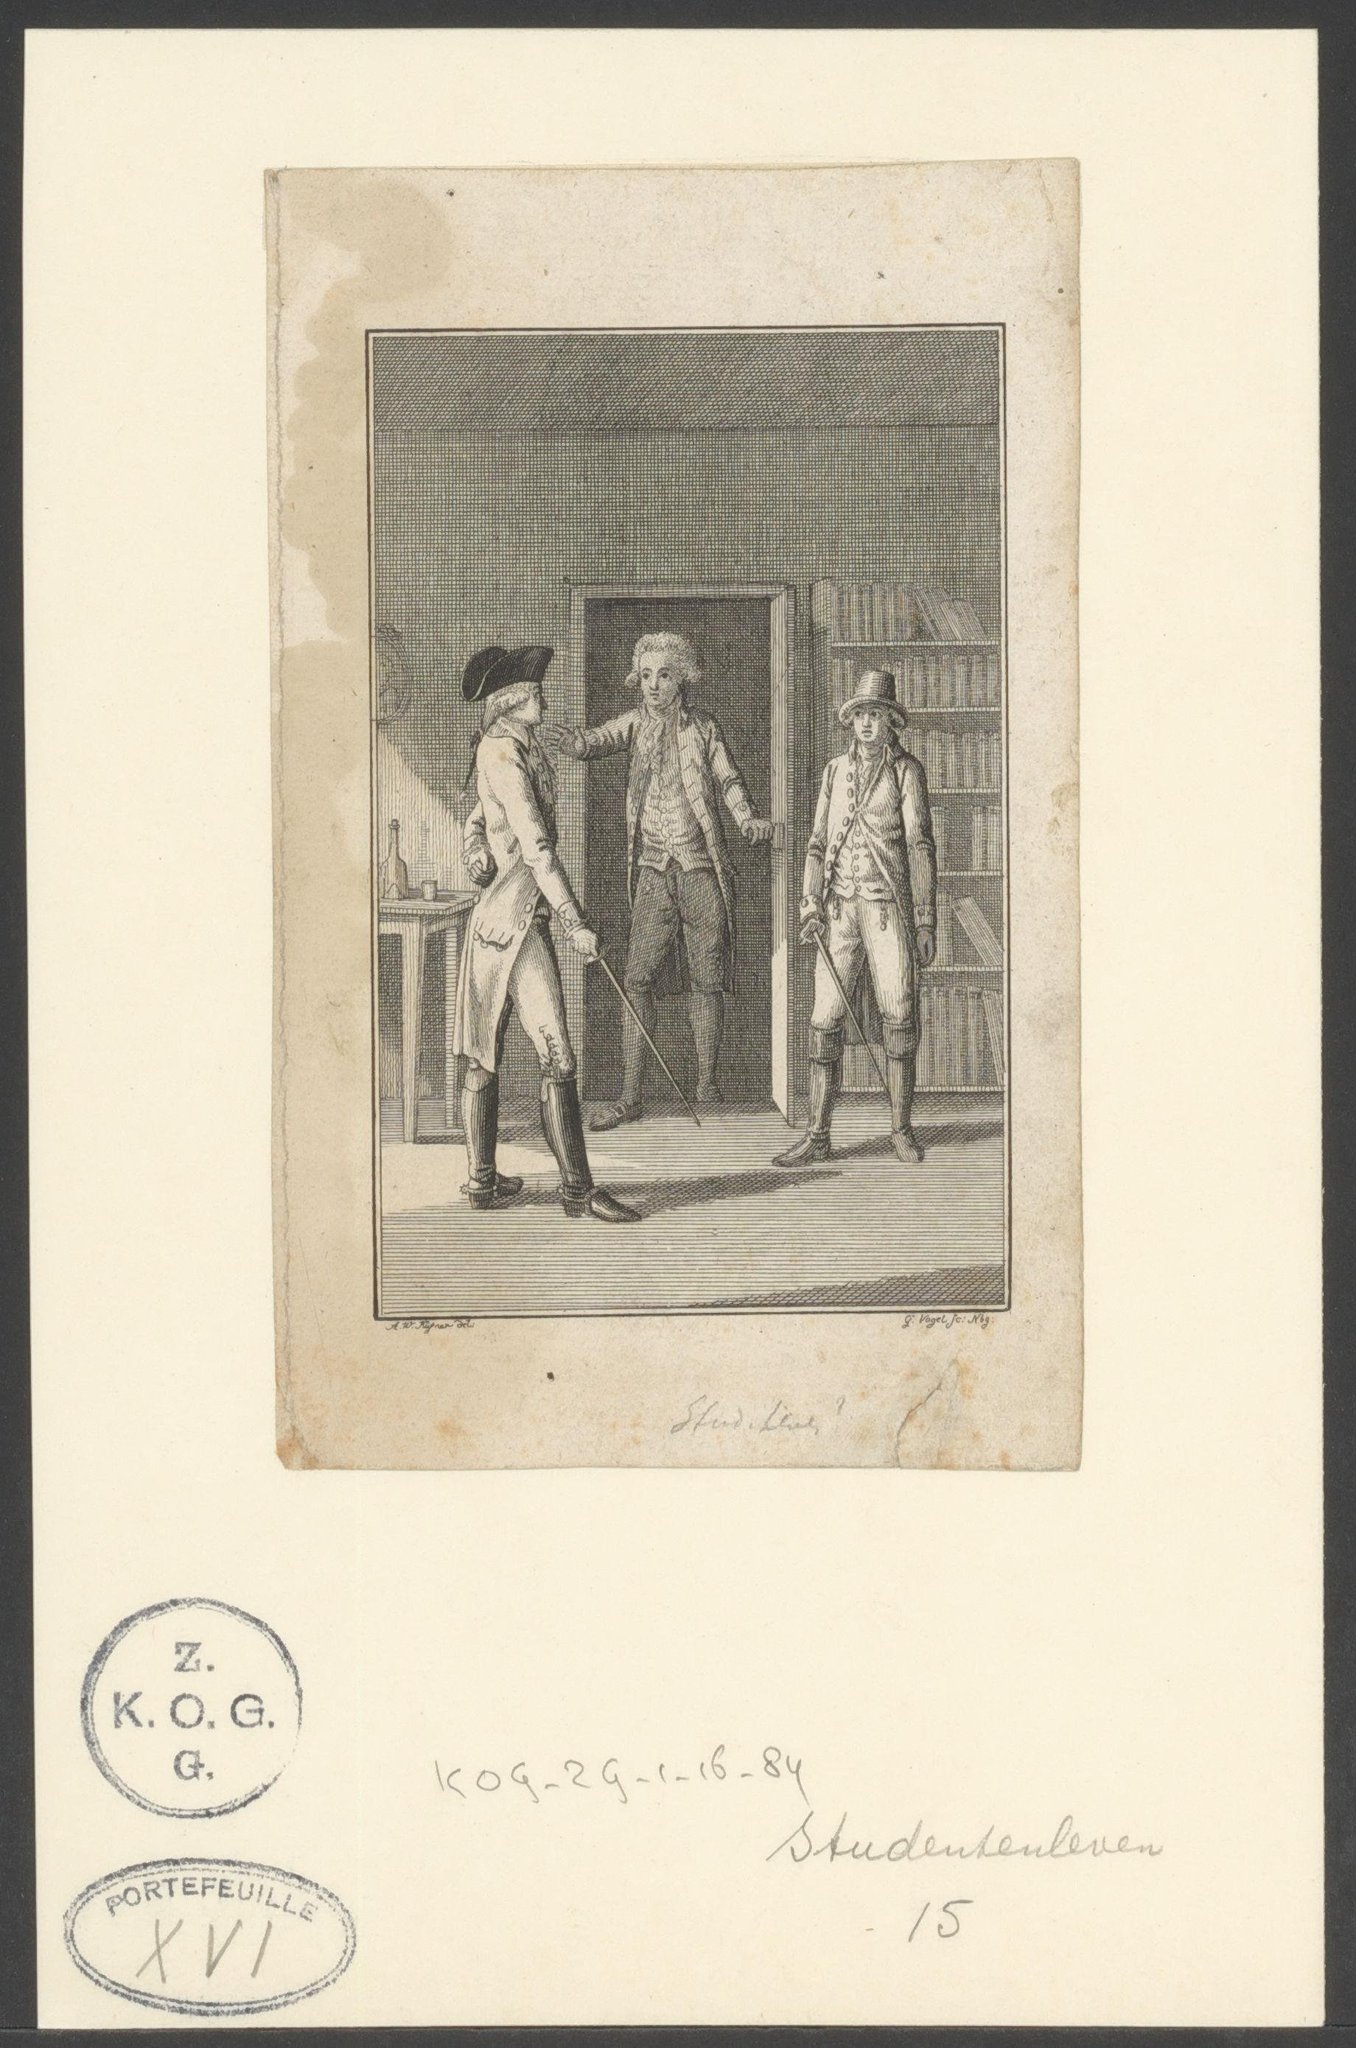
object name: print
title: Twee mannen met sabels bij een student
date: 1777-1810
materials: paper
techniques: etching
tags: student life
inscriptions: stamp, collector's mark: Lugt 1641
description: Onderwerpsrubrieken binnen de Atlas Zeden en Gewoonten: Onderwijs en Wetenschappen, Studentenleven.